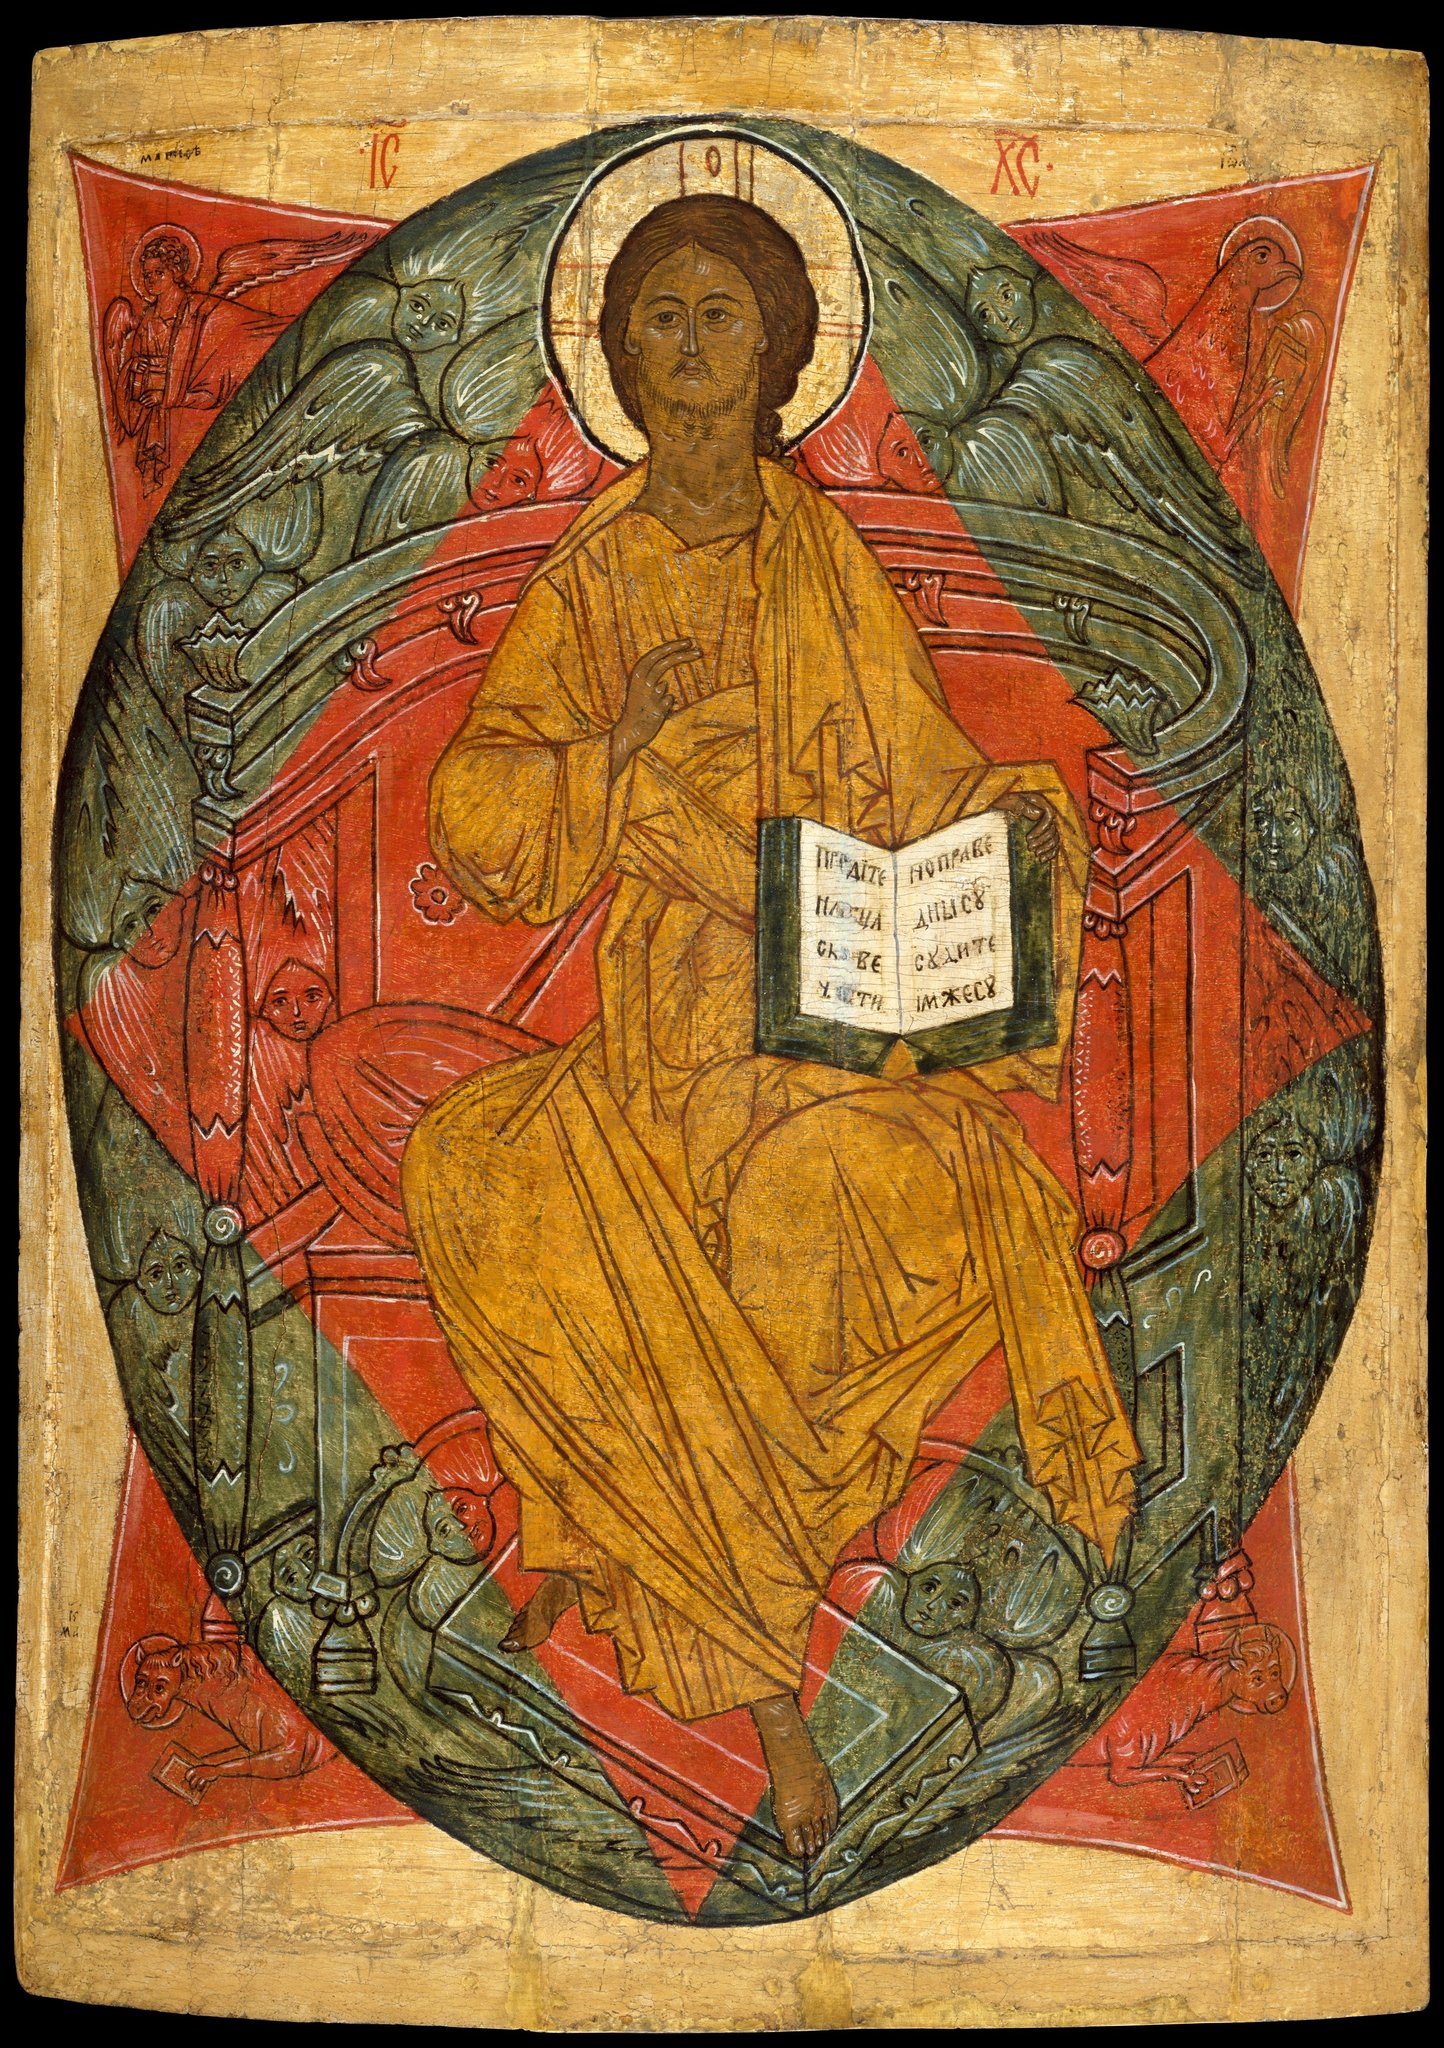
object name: painting, icon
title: Christ in Glory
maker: russian (novgorod?) painter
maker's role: artist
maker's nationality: russian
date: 1470-1499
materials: paint, wood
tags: books,christ